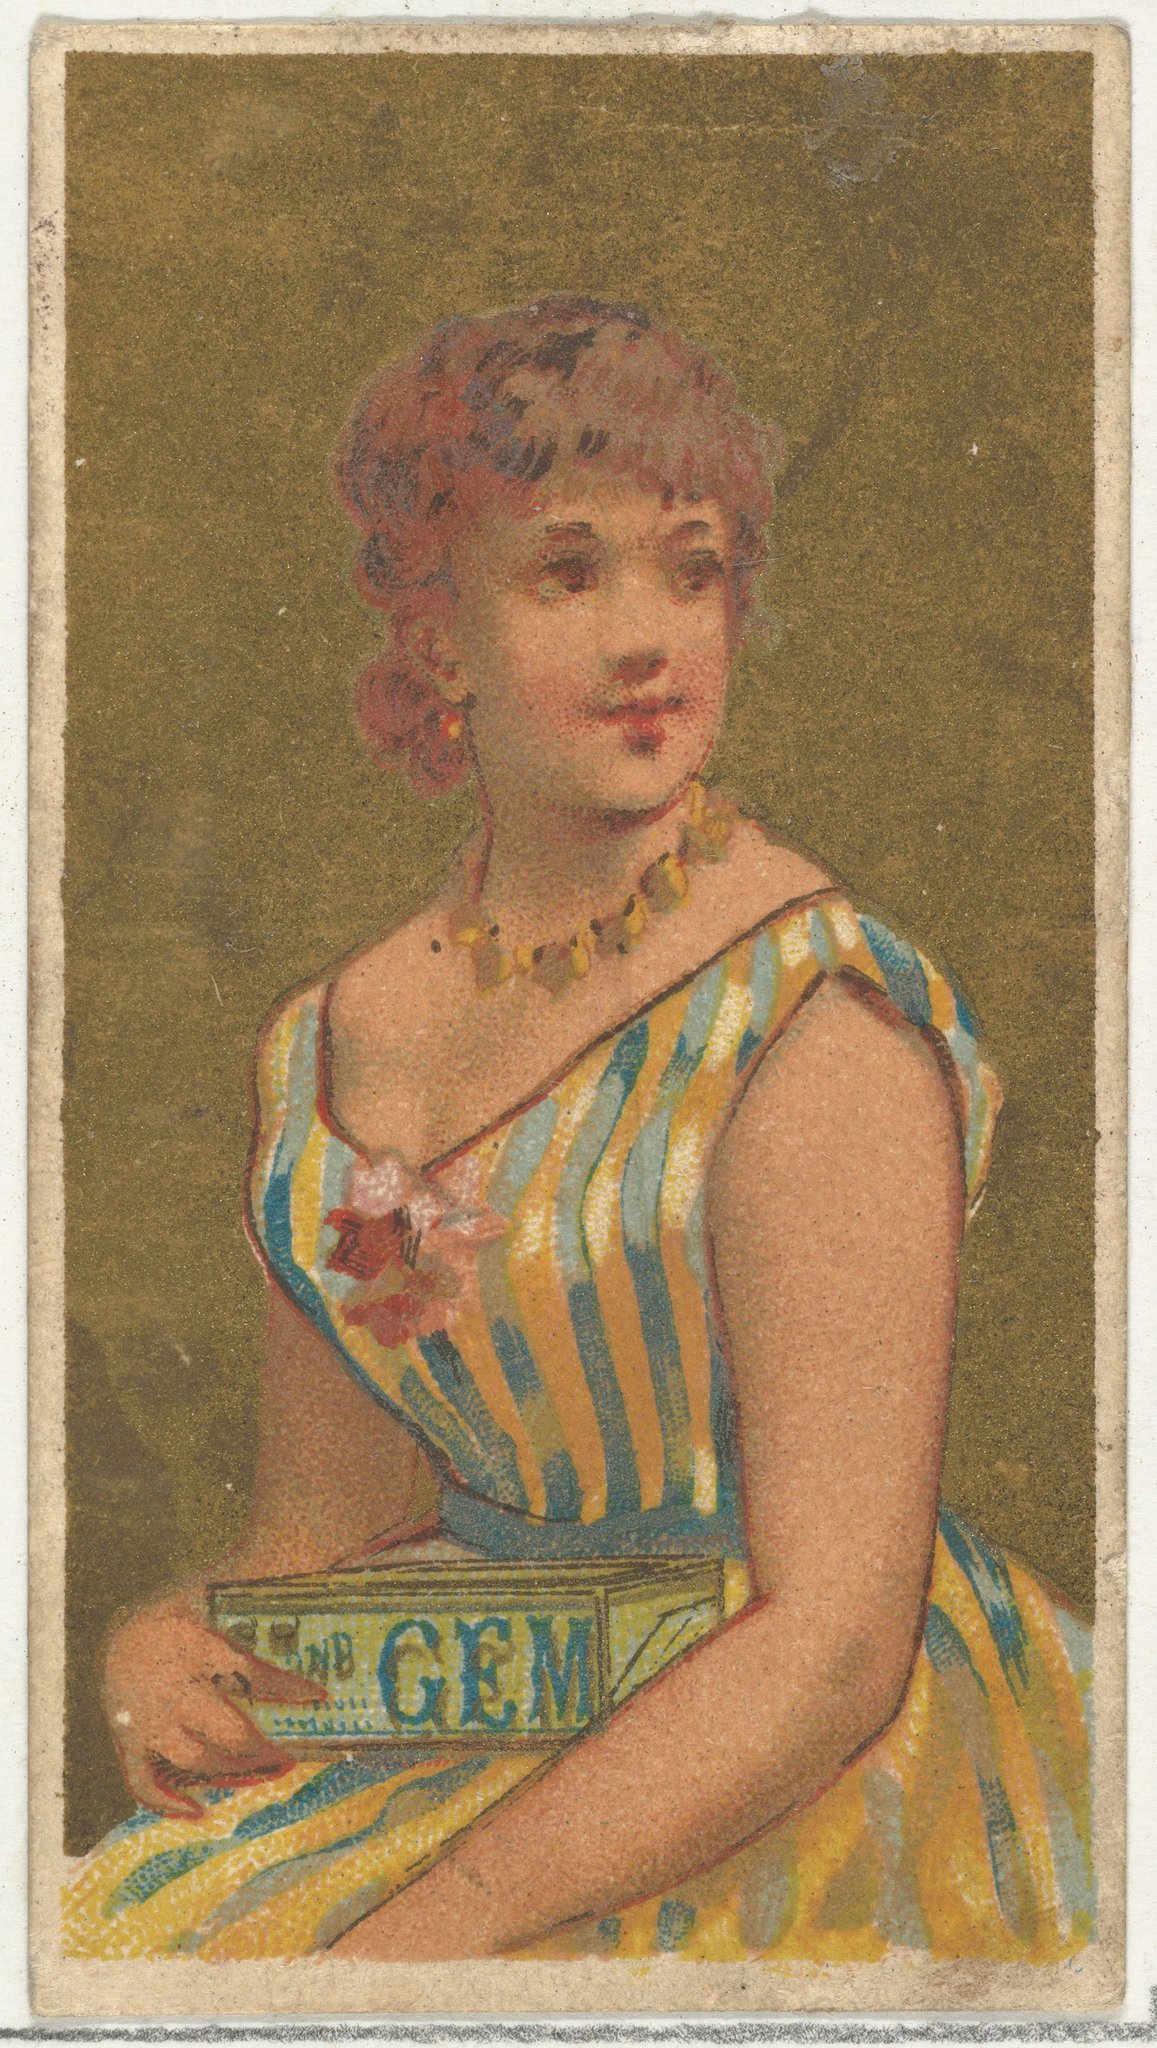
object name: print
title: From the Girls and Children series (N65) promoting Richmond Gem Cigarettes for Allen & Ginter brand tobacco products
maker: allen & ginter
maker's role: publisher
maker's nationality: american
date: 1886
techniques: color lithograph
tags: women